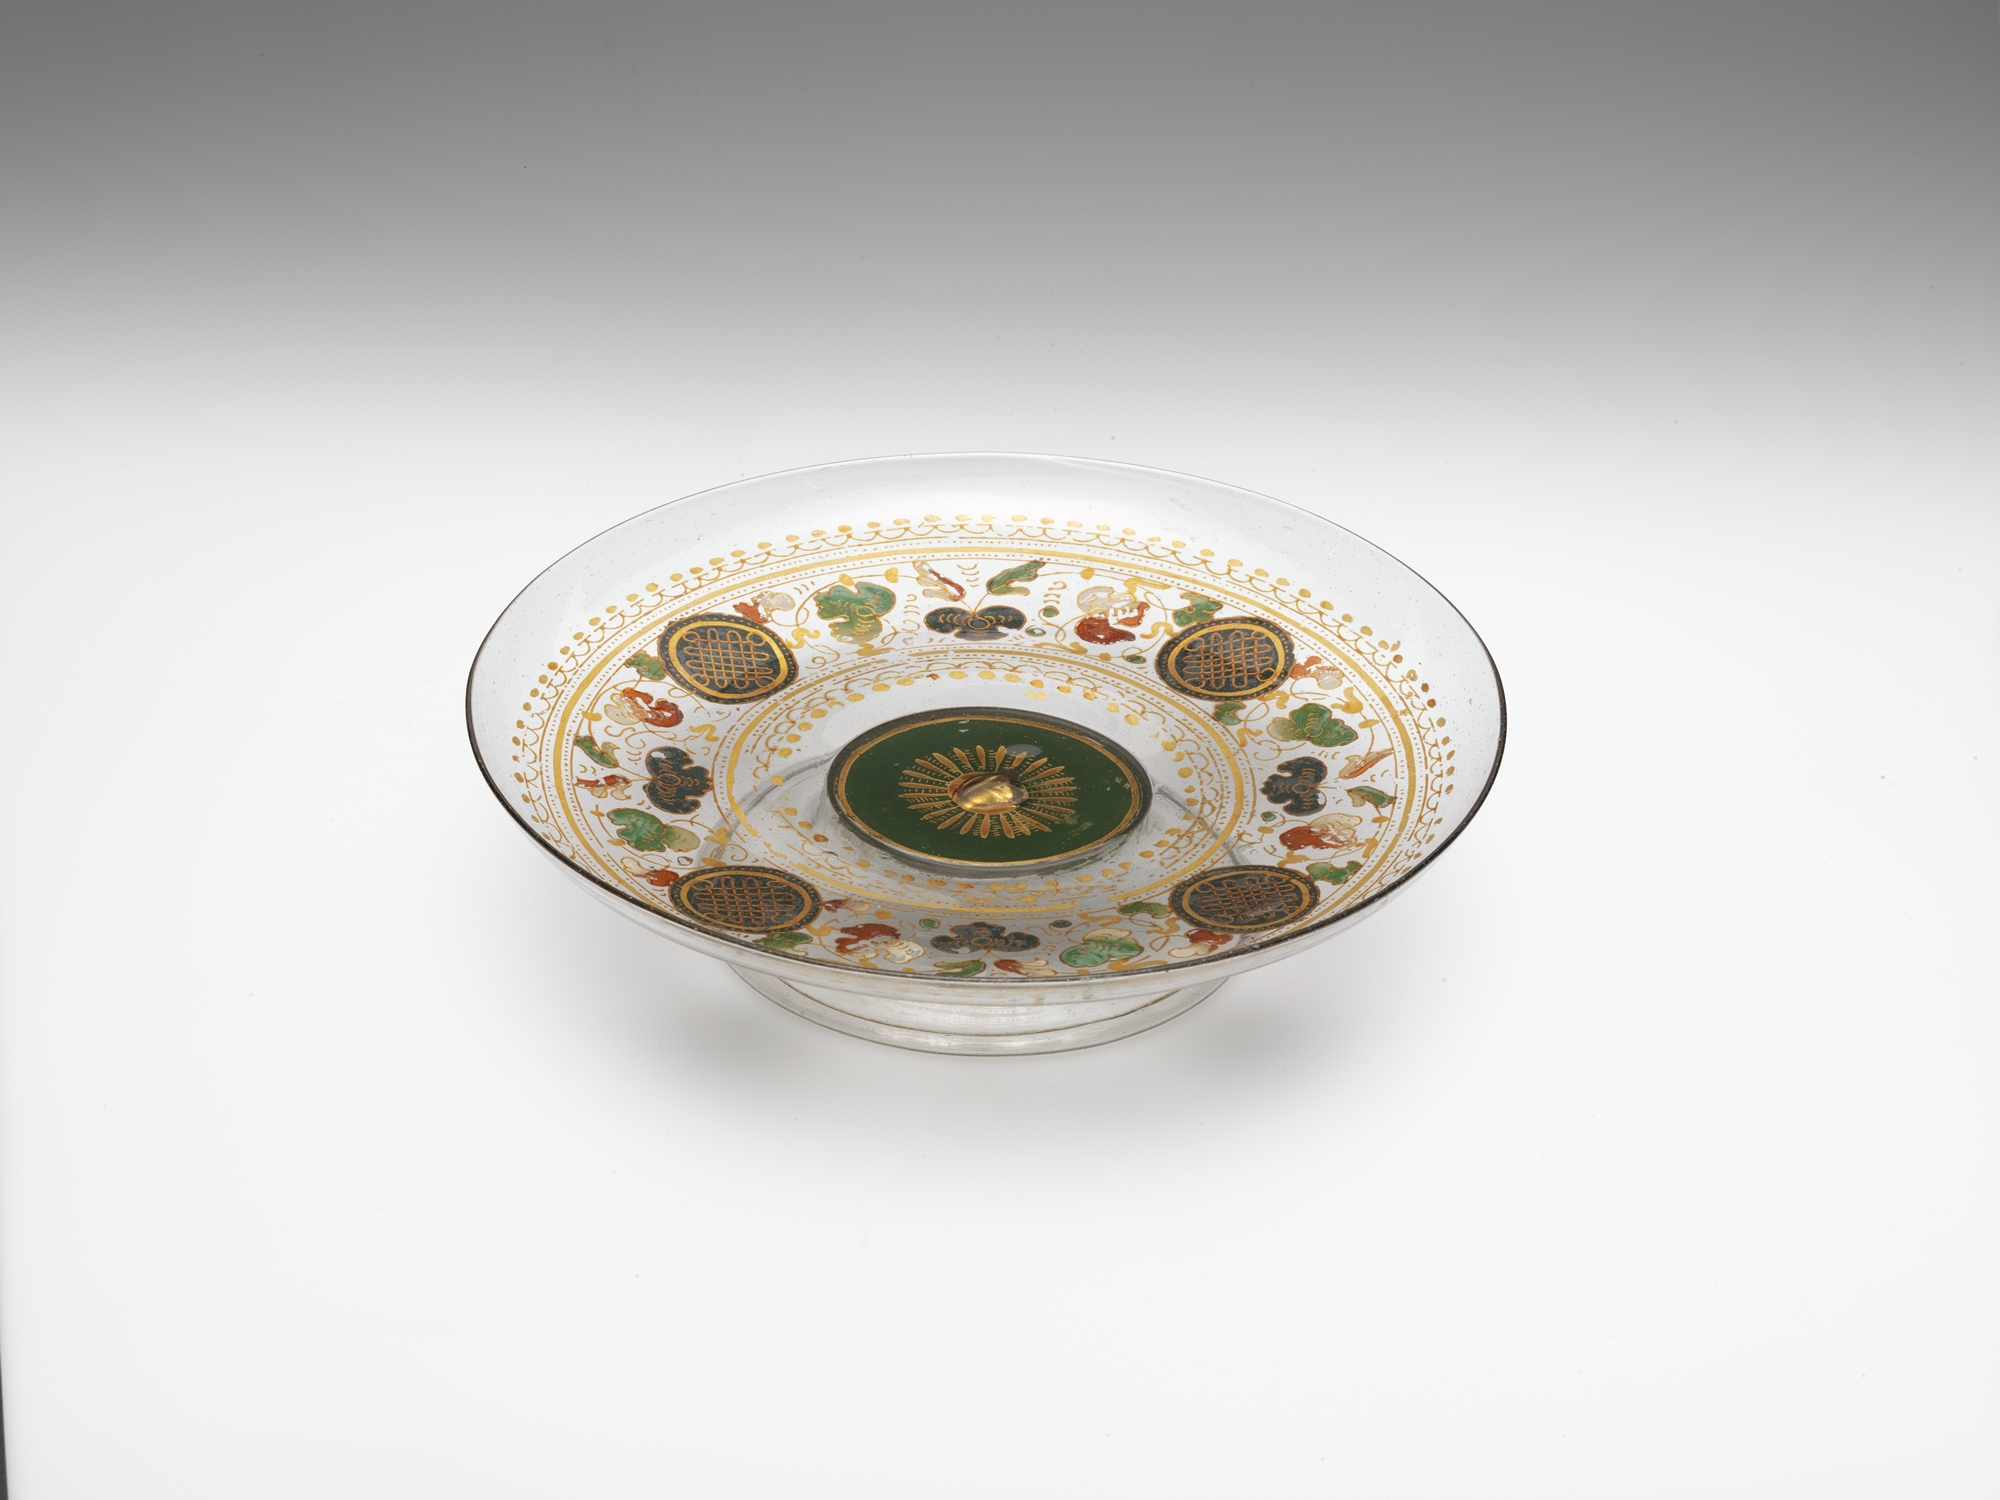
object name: tazza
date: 1534-1566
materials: glass